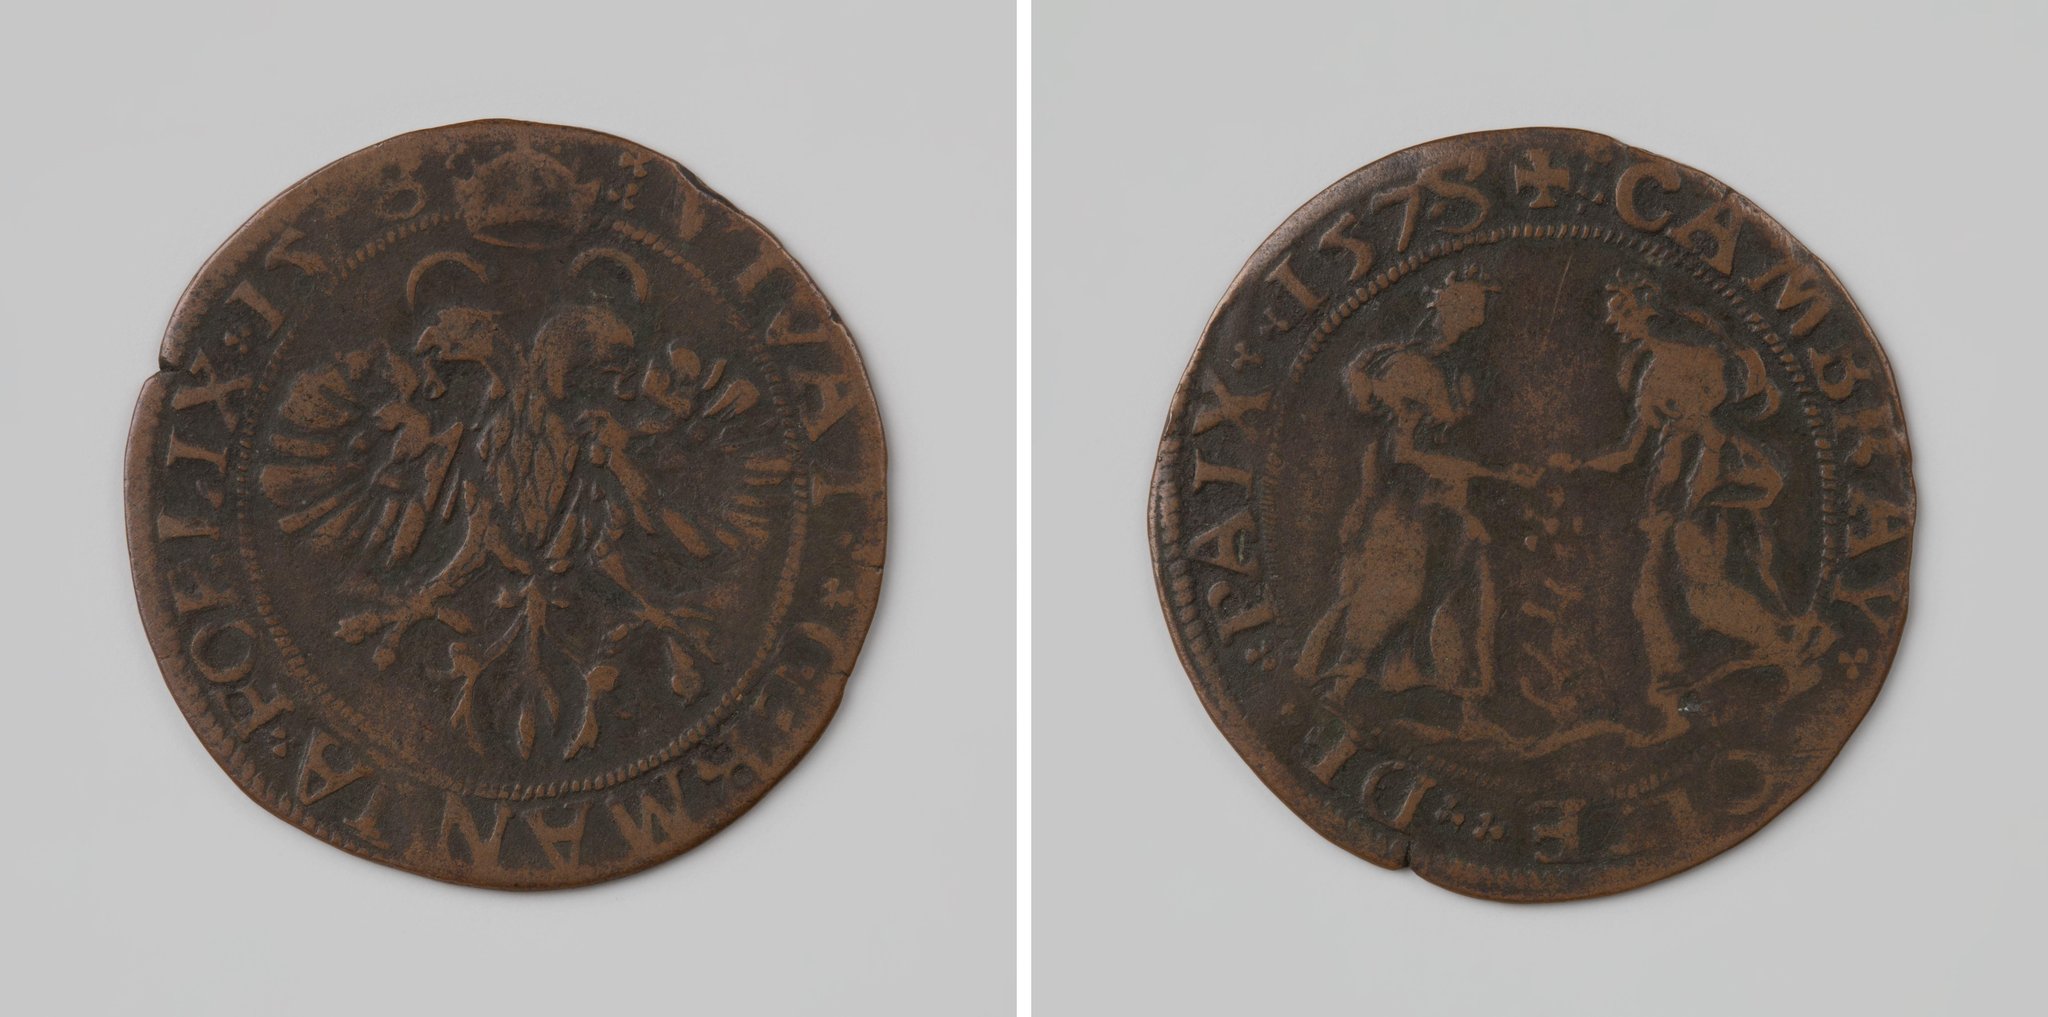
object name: jeton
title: Godsdienstrust te Kamerijk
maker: Anonymous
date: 1578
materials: copper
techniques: striking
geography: belgium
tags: cambrai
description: Koperen penning. Voorzijde: tweekoppige adelaar onder kroon binnen omschrift. Keerzijde: twee vrouwen geven elkaar hand boven bloeiende struik binnen omschrift